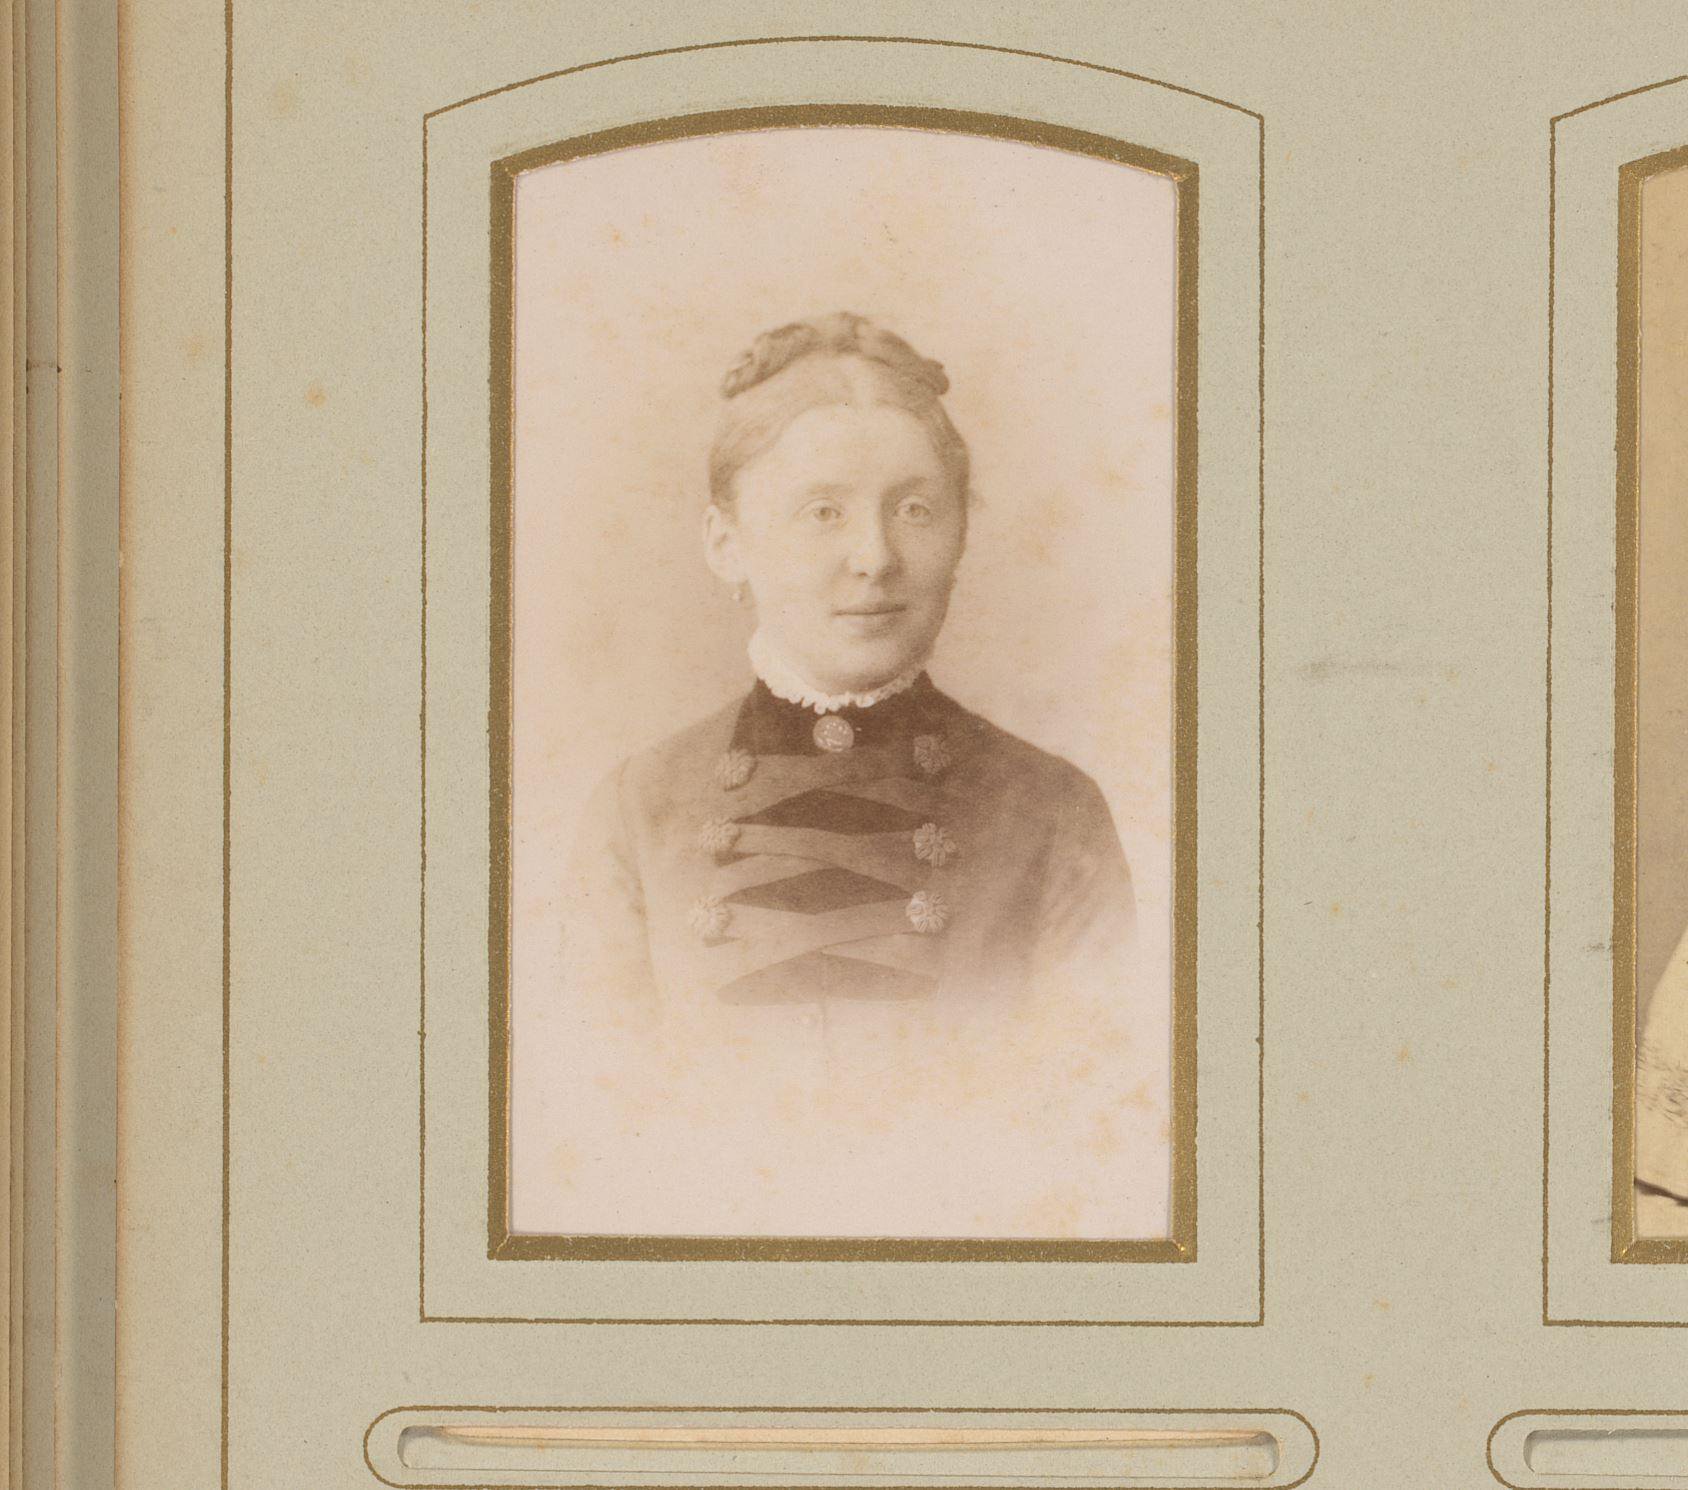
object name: photograph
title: Portret van een jonge vrouw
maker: edouard fabronius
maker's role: fotograaf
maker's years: 1847-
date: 1882-1891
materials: cardboard, photographic support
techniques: albumen print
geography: brussels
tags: adolescent, young woman, maiden, historical persons - bb - woman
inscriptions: inscription: ‘Photographie/ FABRONIUS/ Rue Neuve 9,/ Bruxelles.’